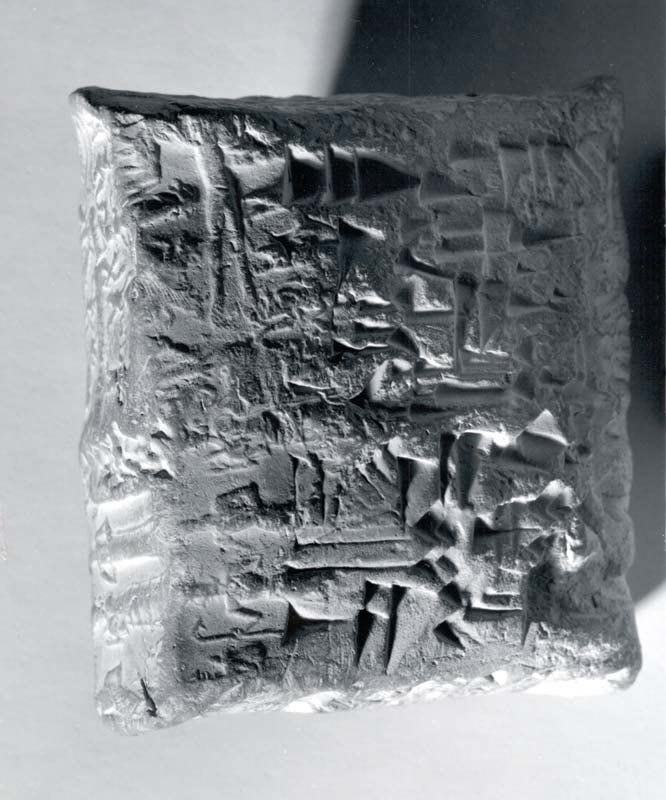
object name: cuneiform tablet case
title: Cuneiform tablet case impressed with four cylinder seals, for cuneiform tablet 86.11.214a: field rental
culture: babylonian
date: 1749-1712 BCE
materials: clay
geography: mesopotamia